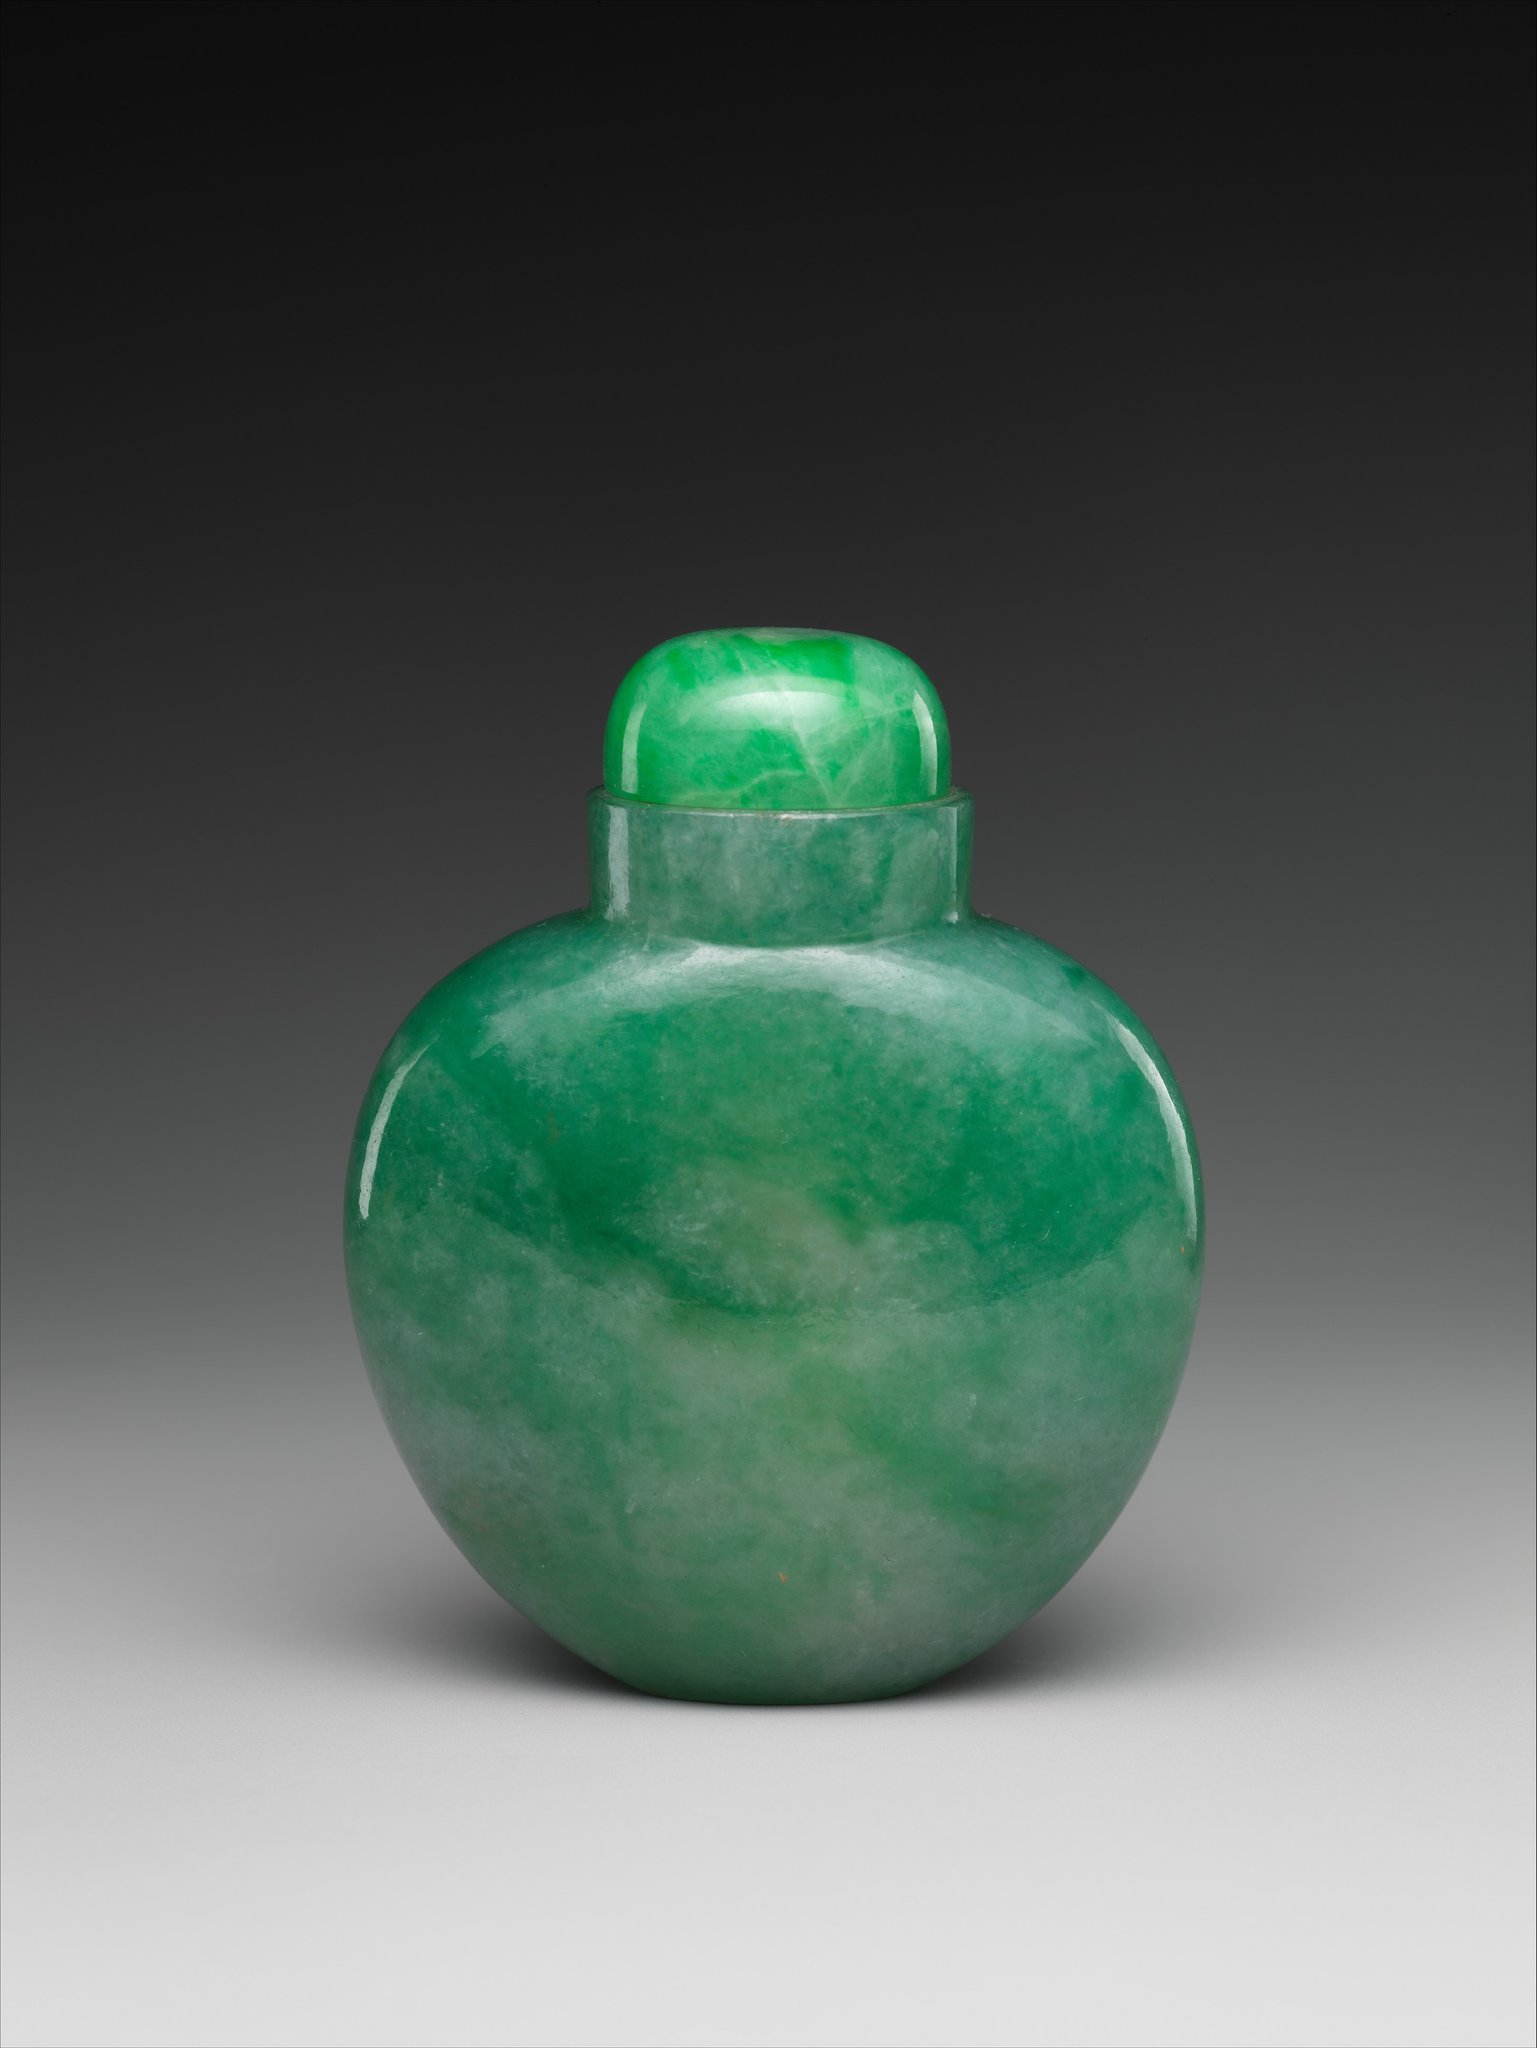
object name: snuff bottle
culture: chinese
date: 1801-1900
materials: jade